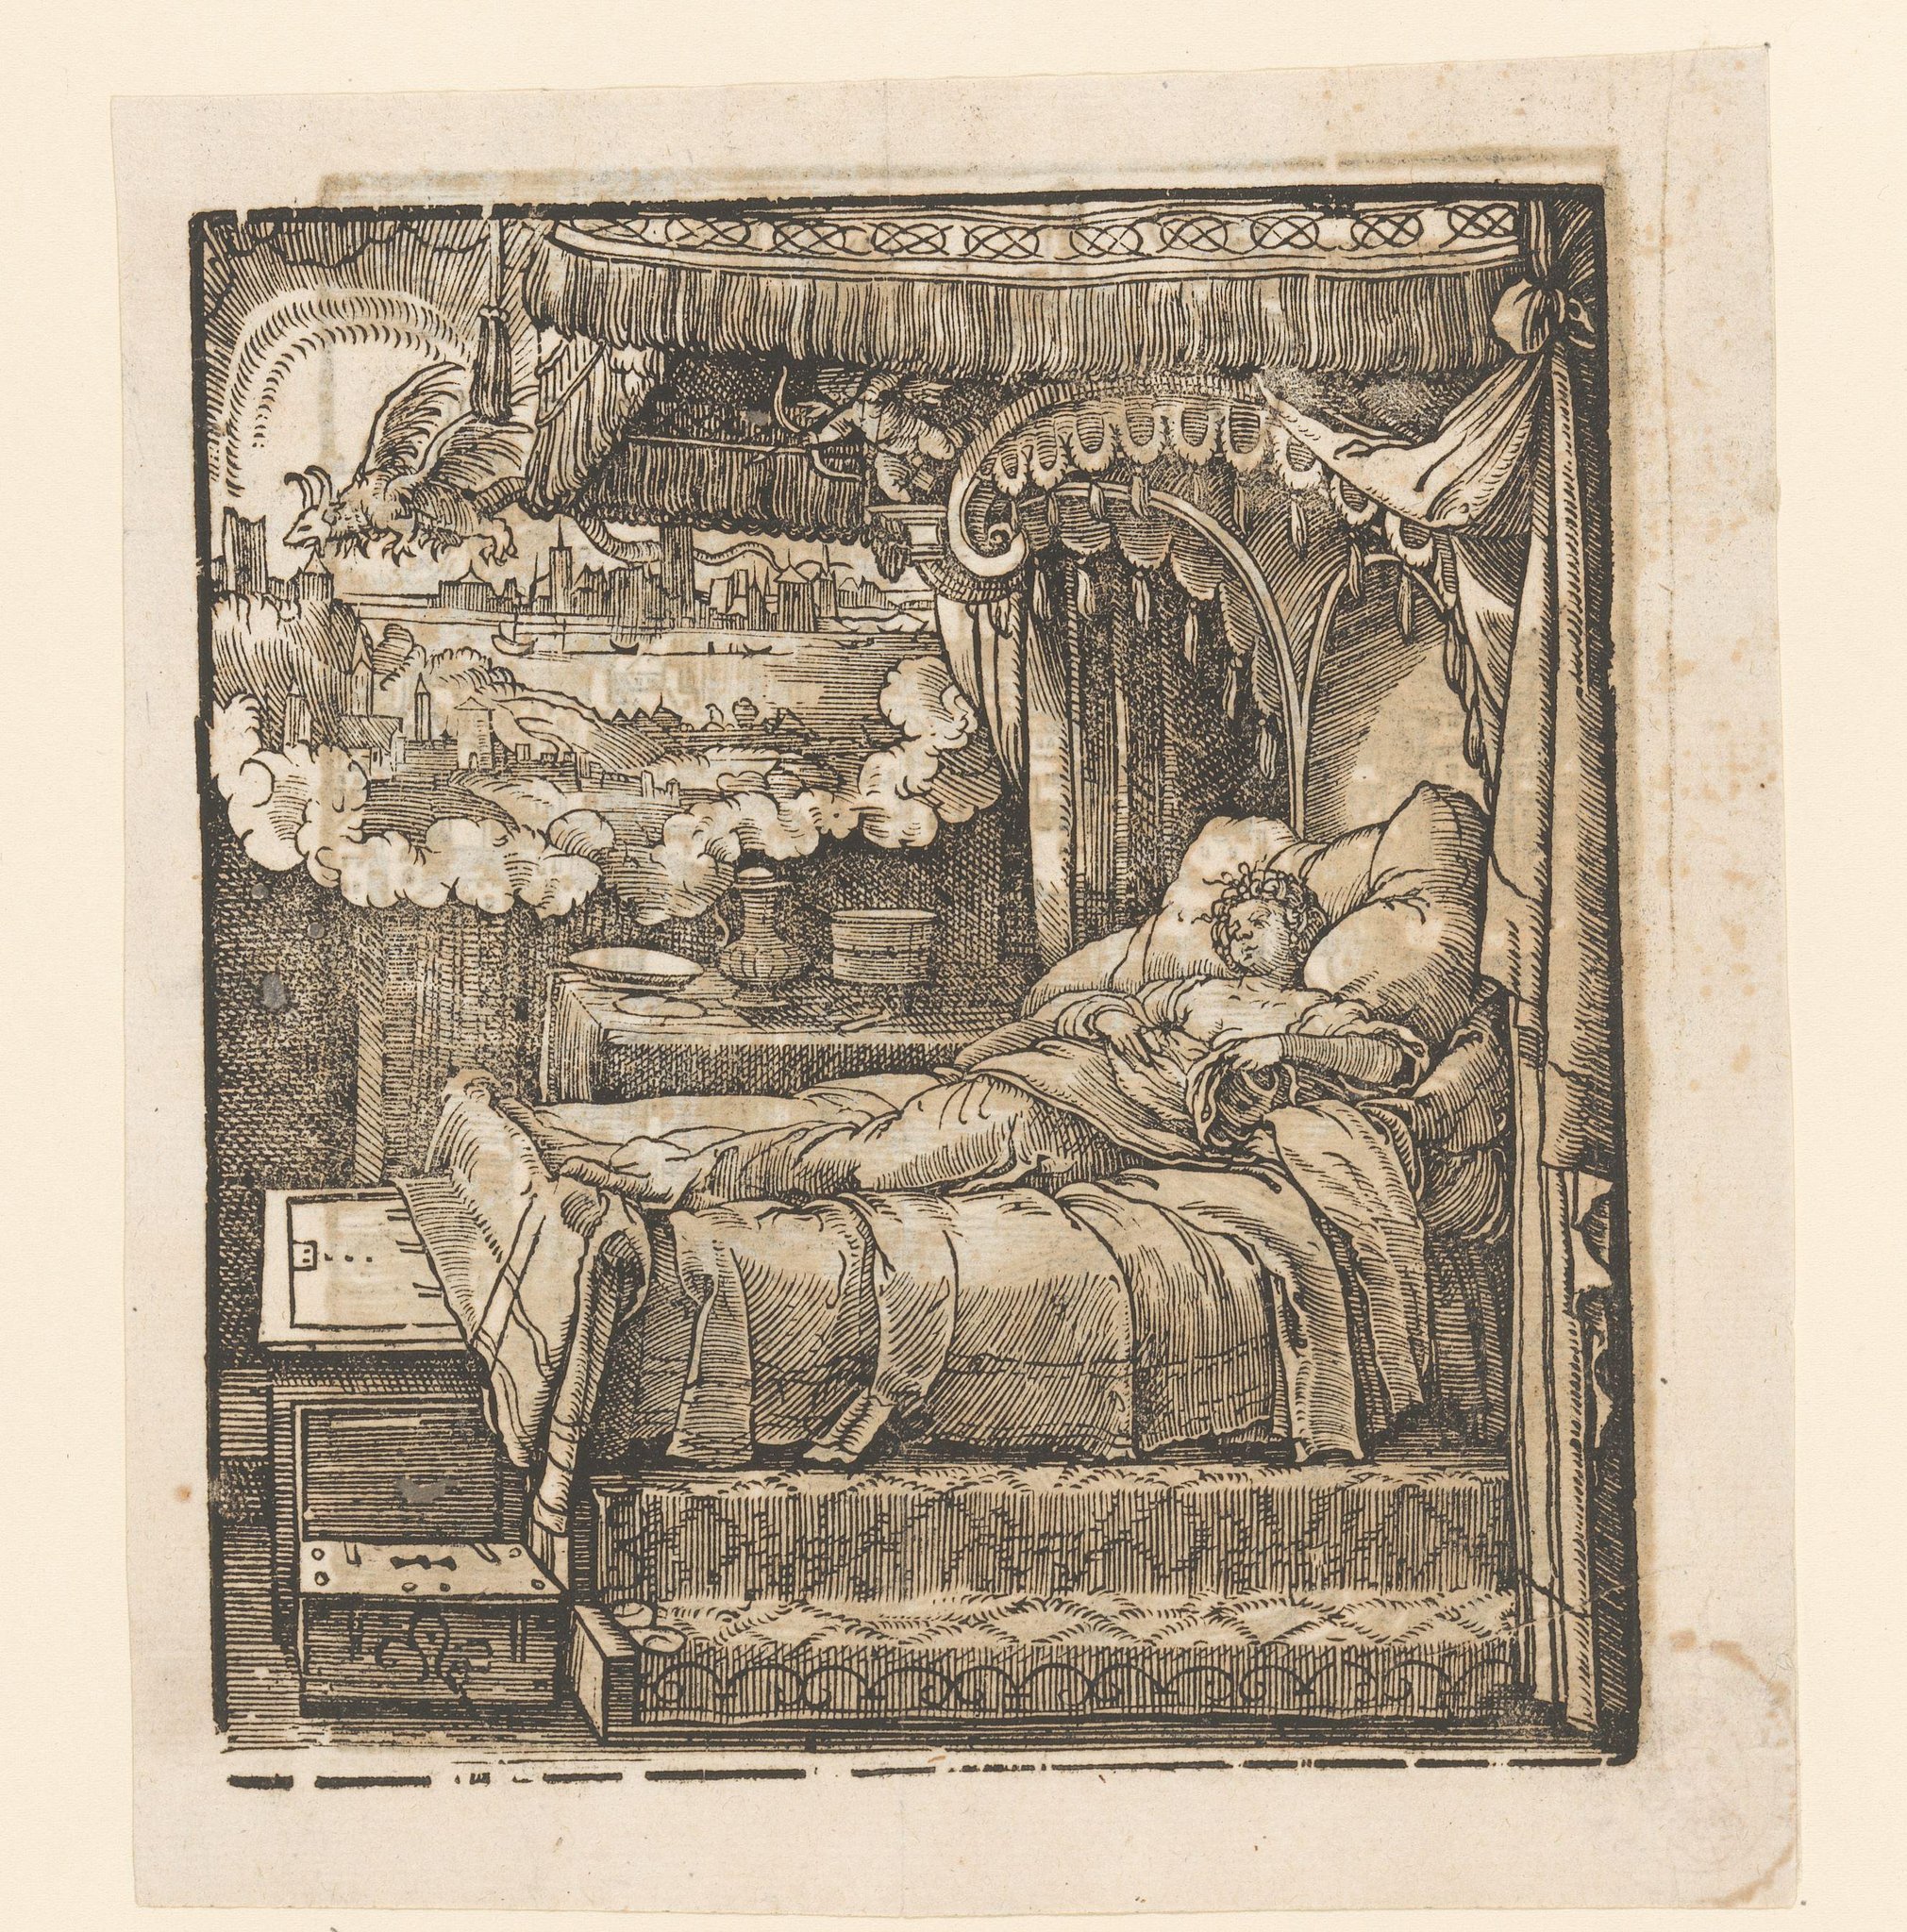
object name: print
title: Droom van Skanderbegs moeder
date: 1533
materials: paper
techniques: woodcut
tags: dragon, prophetic dream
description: Prent afkomstig uit: Barletius, Marinus. Scanderbeg. Augsburg: Heinrich Steiner, 1533.